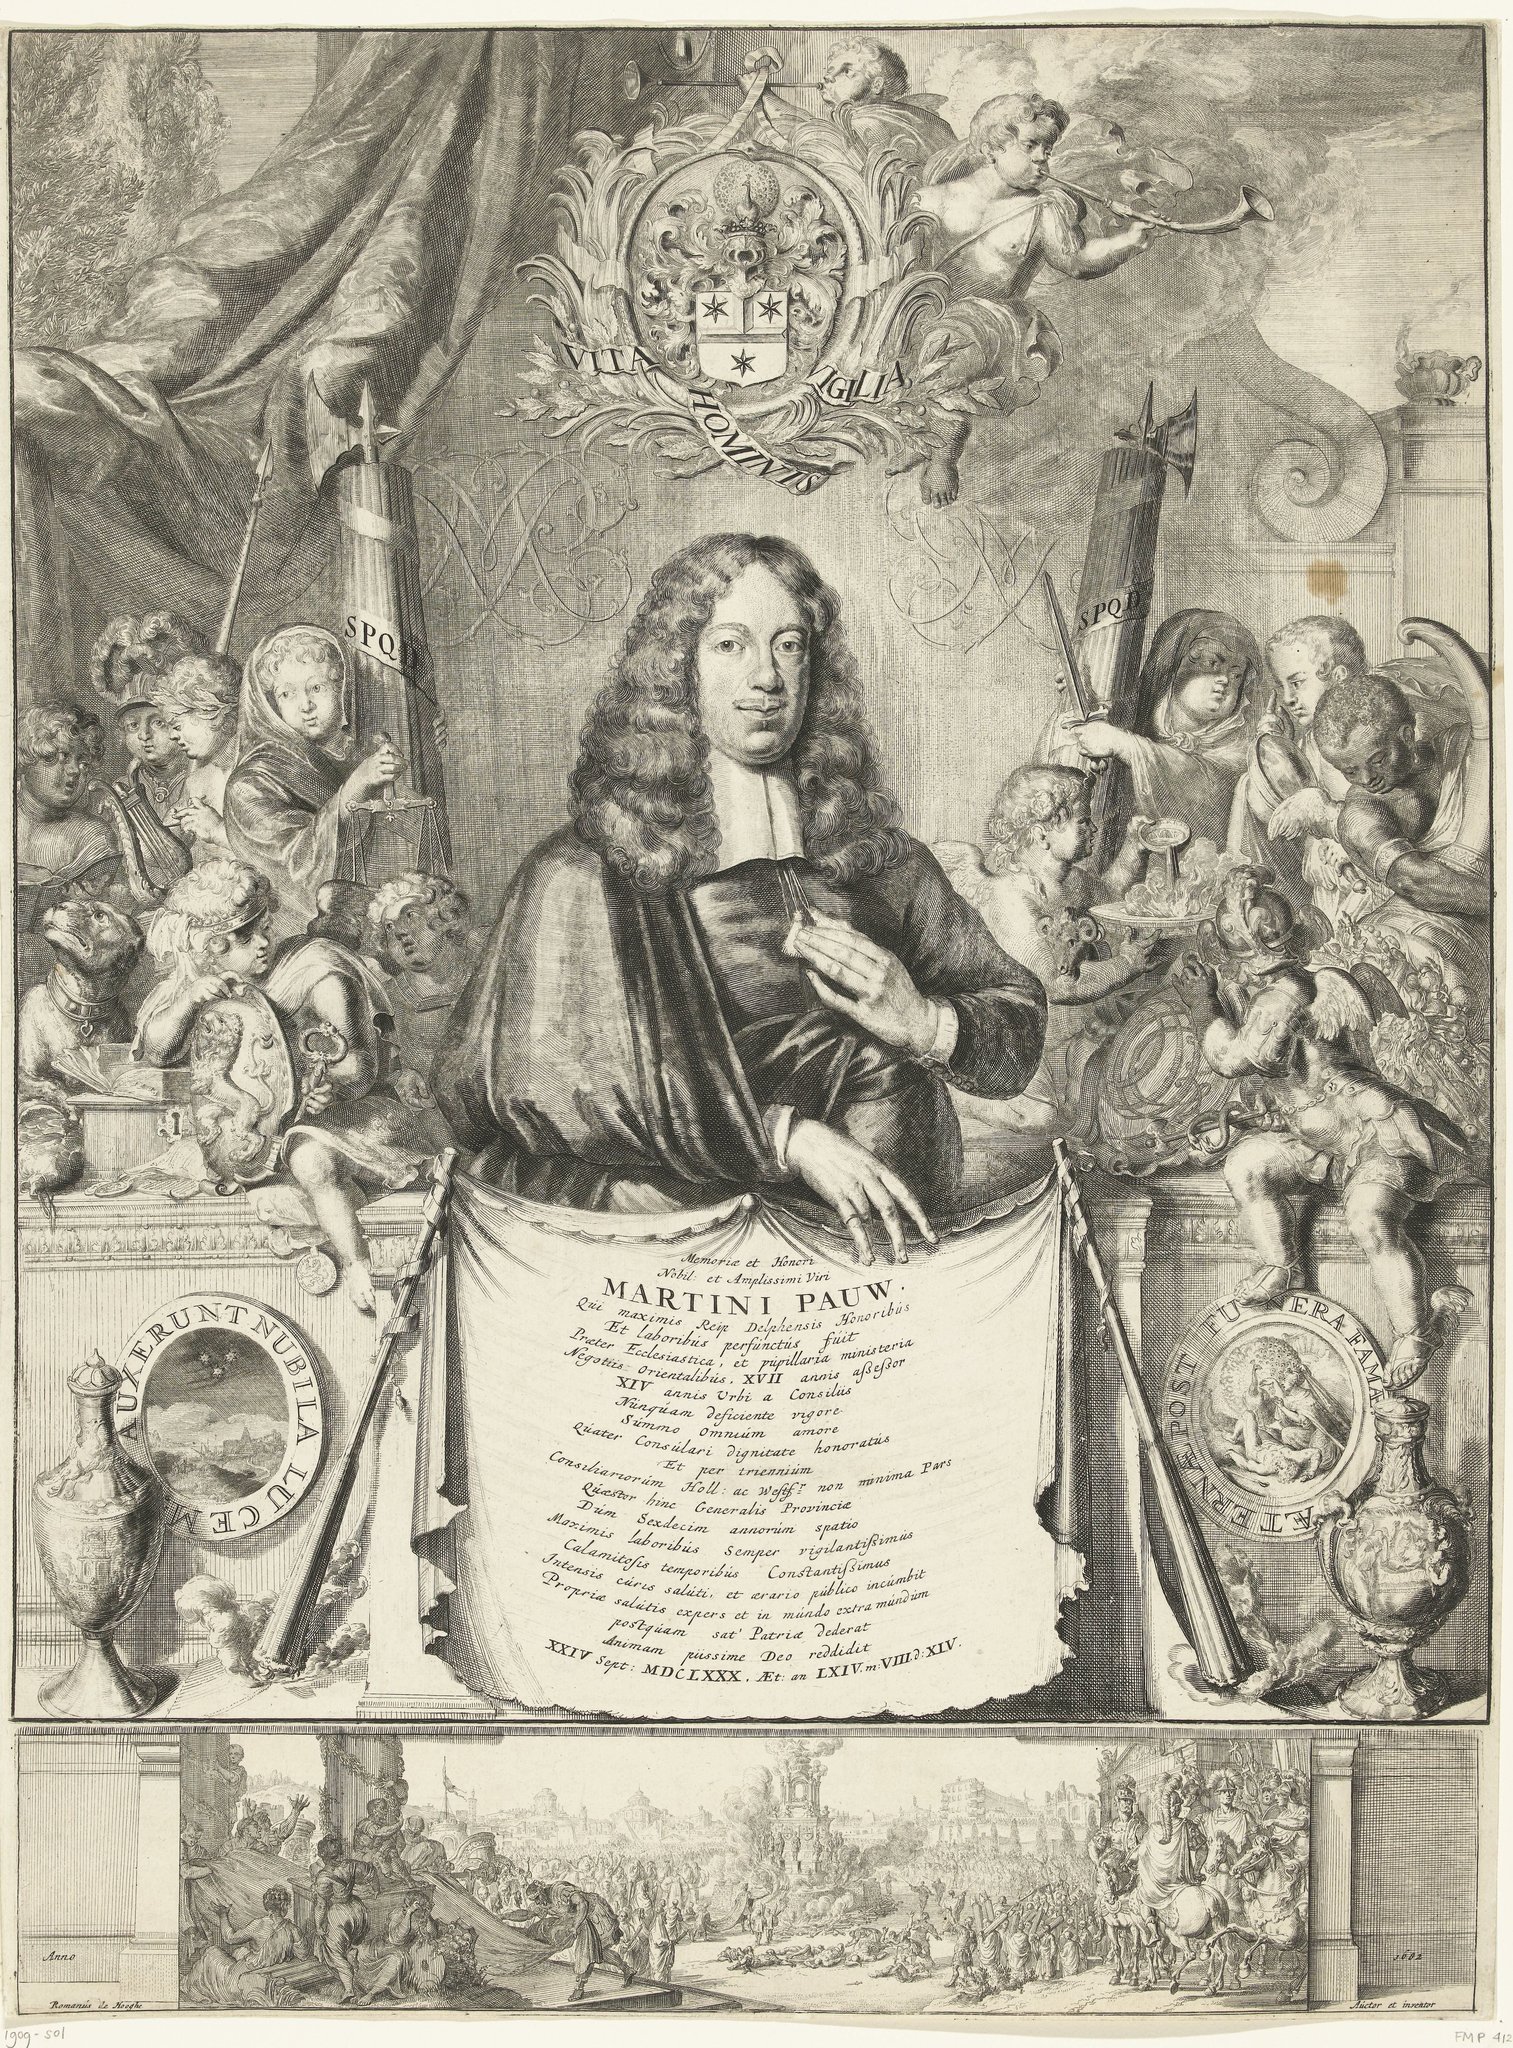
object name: print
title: Portret van Martinus Pauw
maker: romeyn de hooghe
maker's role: draughtsman, goldsmith, painter, print maker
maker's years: 1645-1708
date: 1682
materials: paper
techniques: etching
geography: netherlands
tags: martinus pauw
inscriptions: date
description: Portret van Martinus Pauw. Ten halven lijve weergegeven, met op beenhoogte een doek met tekst. Daaronder een Romeinse voorstelling van een verbranding. Boven Pauw een heraldisch wapen en twee putti. Links en rechts van hem allegorische figuren.